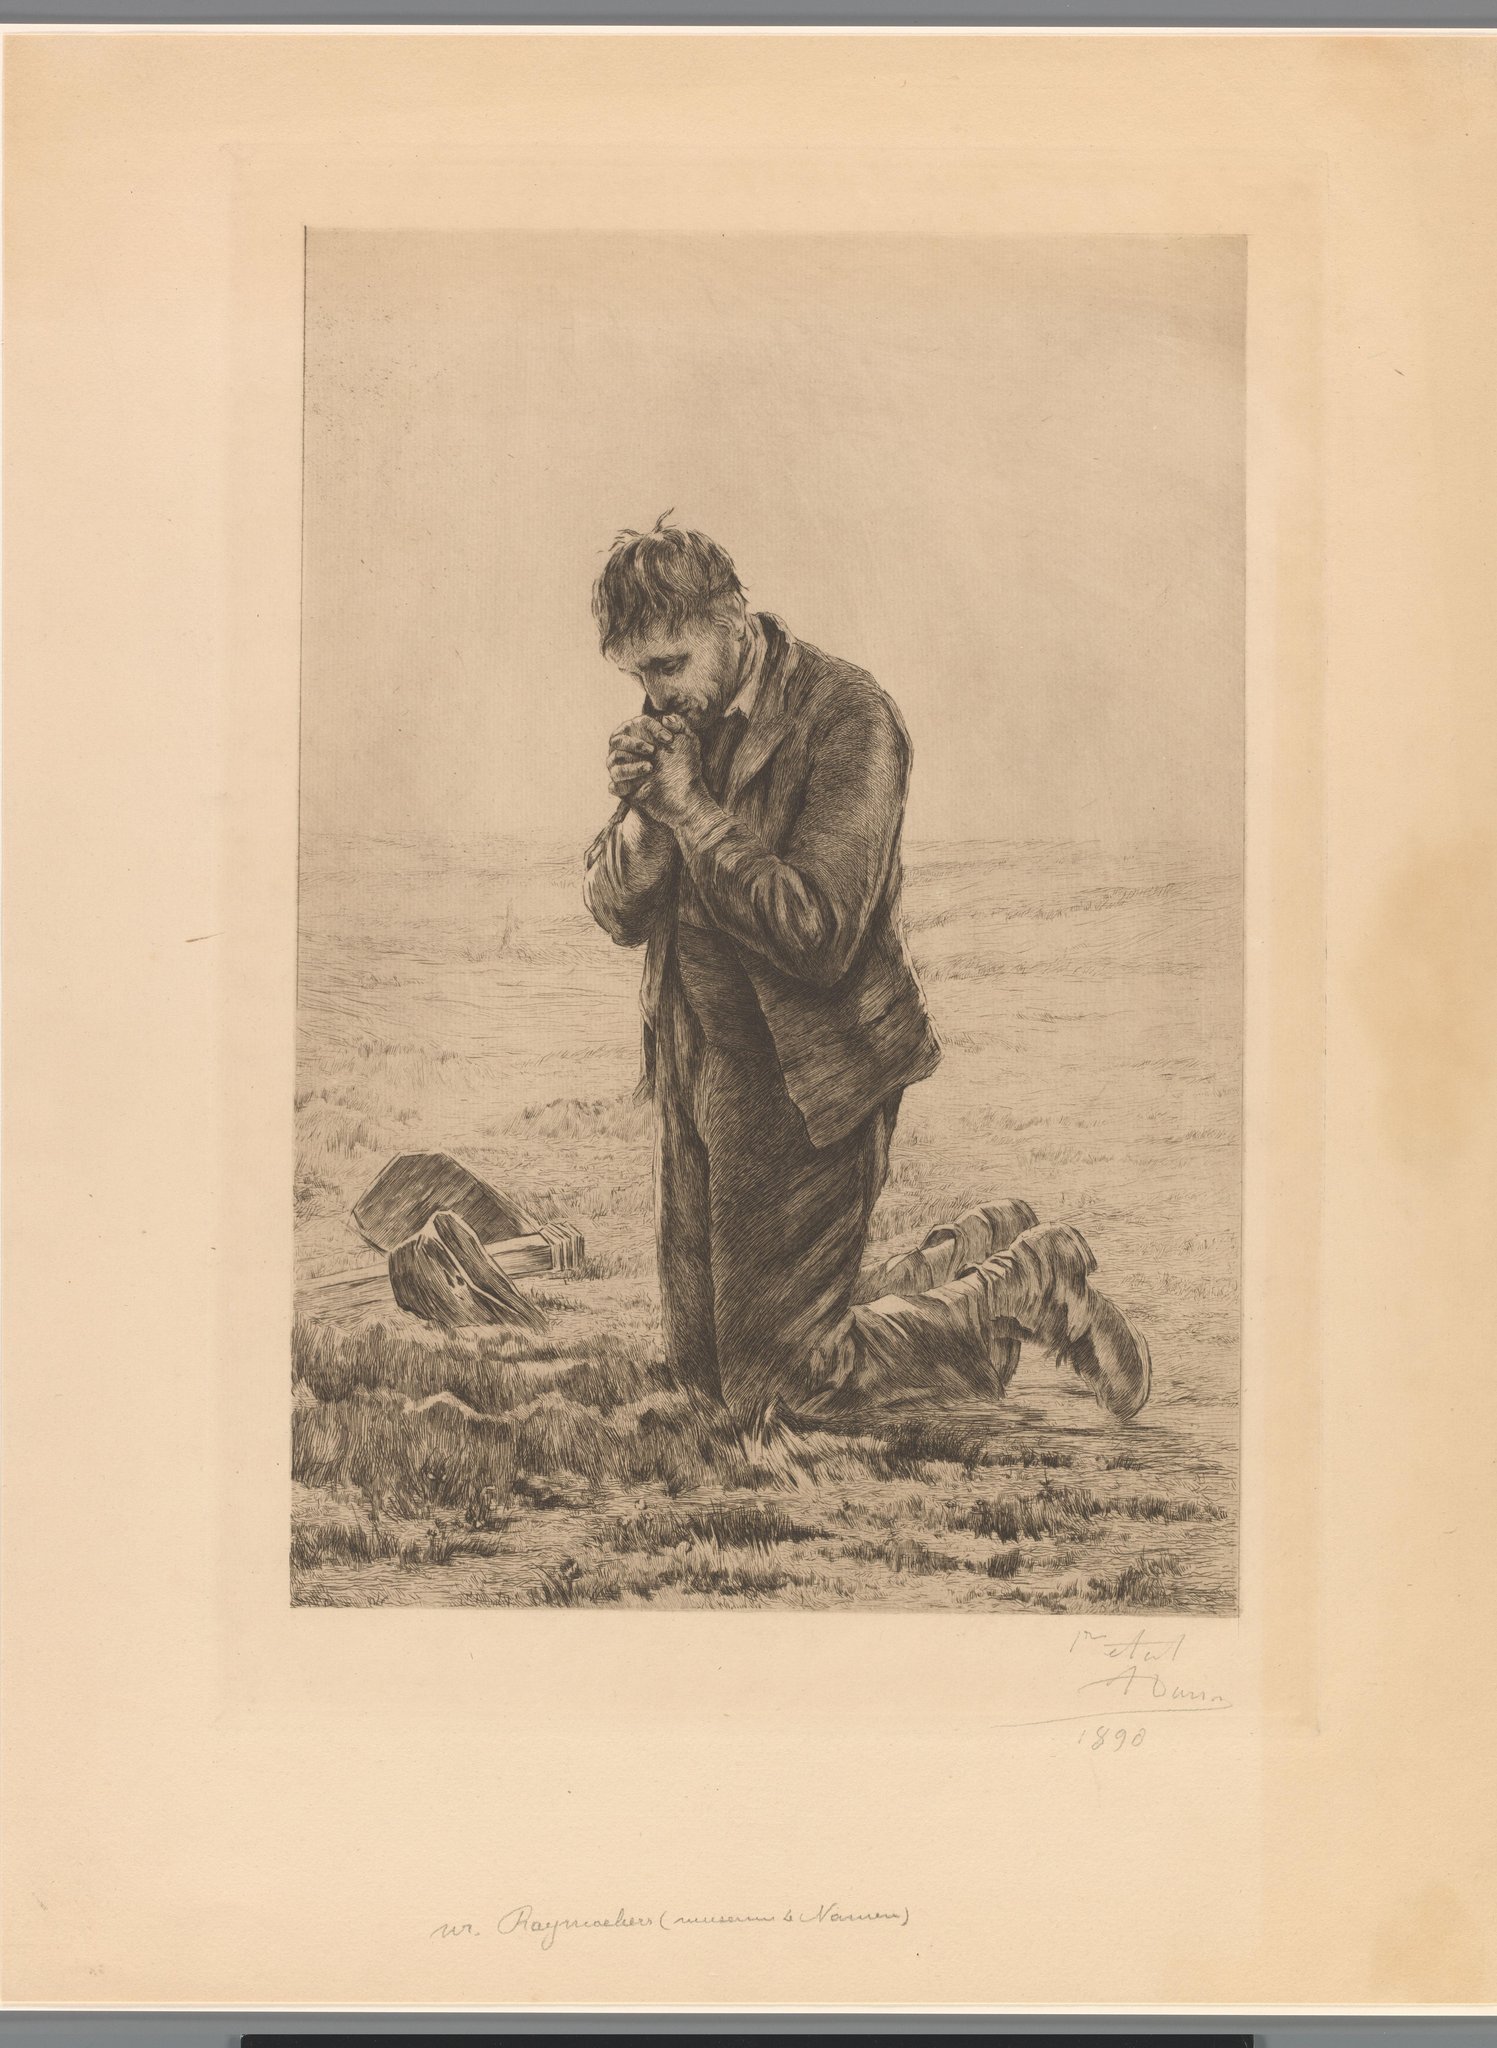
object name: print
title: Landarbeider knielt in het veld voor zijn gebed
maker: auguste danse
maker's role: print maker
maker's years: 1829-1929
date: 1898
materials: paper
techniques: drypoint, etching, intaglio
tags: daily (vocal) prayer by one person, farmers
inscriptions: collector's mark: Lugt 2228, annotation: ‘1er etat’